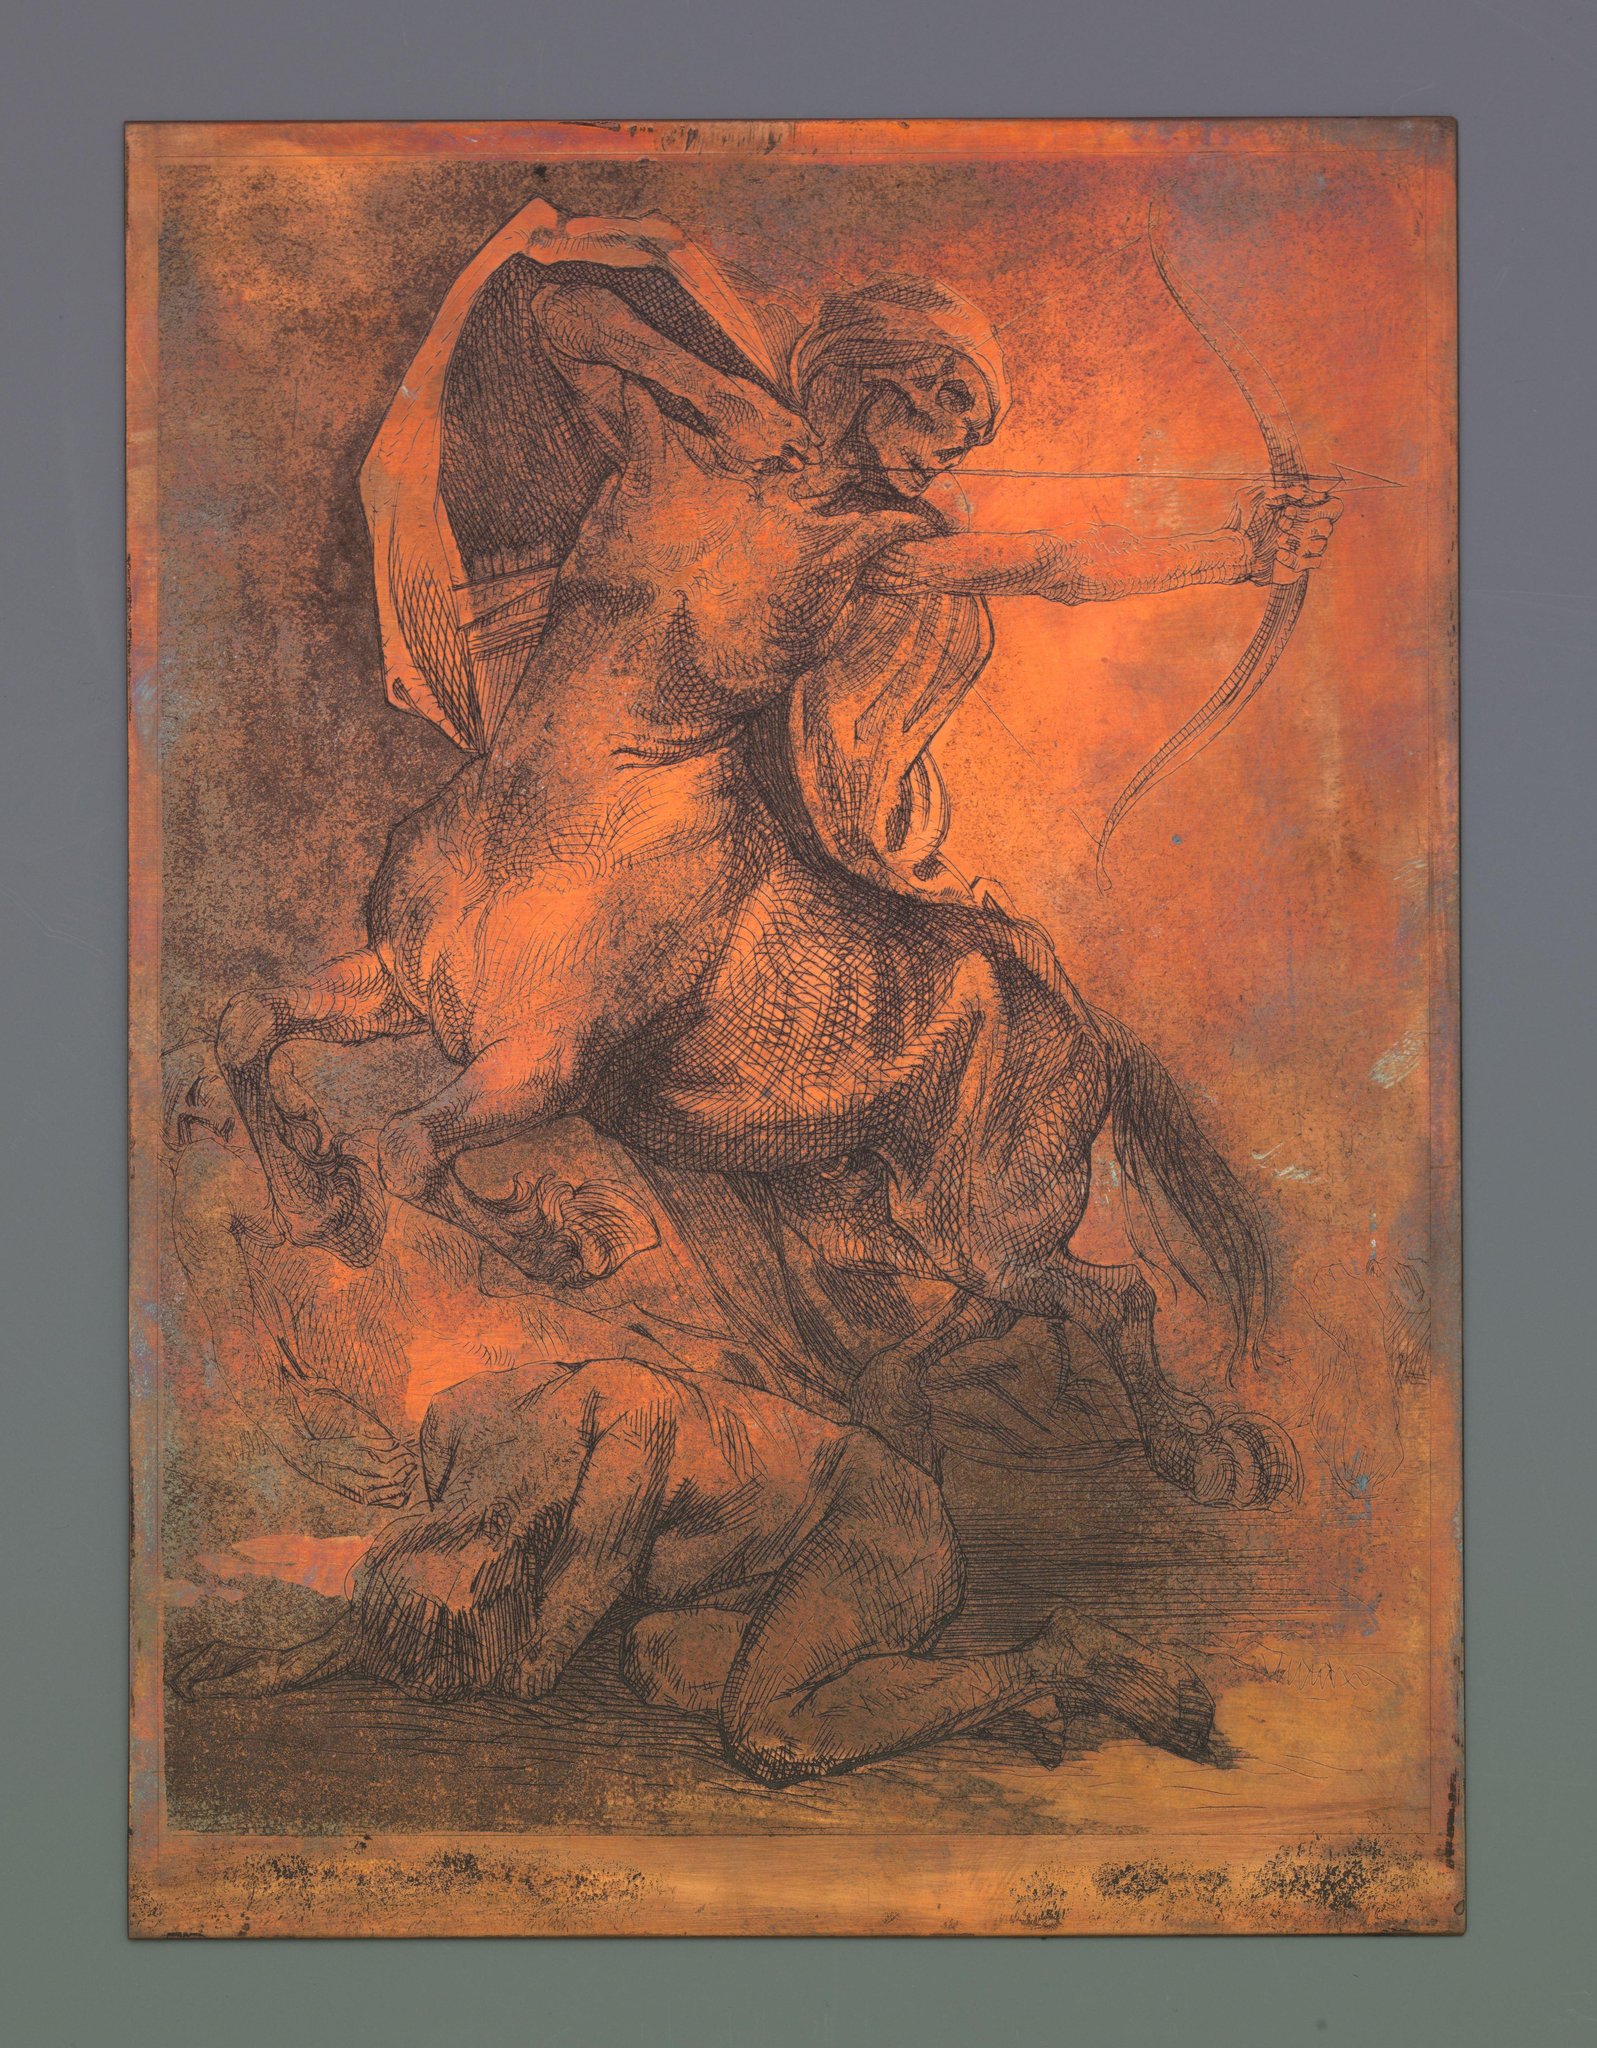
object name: copper plate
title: De dood als centaur met pijl en boog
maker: johannes josephus aarts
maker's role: draughtsman, print maker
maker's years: 1871-1934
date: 1881-1934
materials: copper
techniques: aquatint, etching